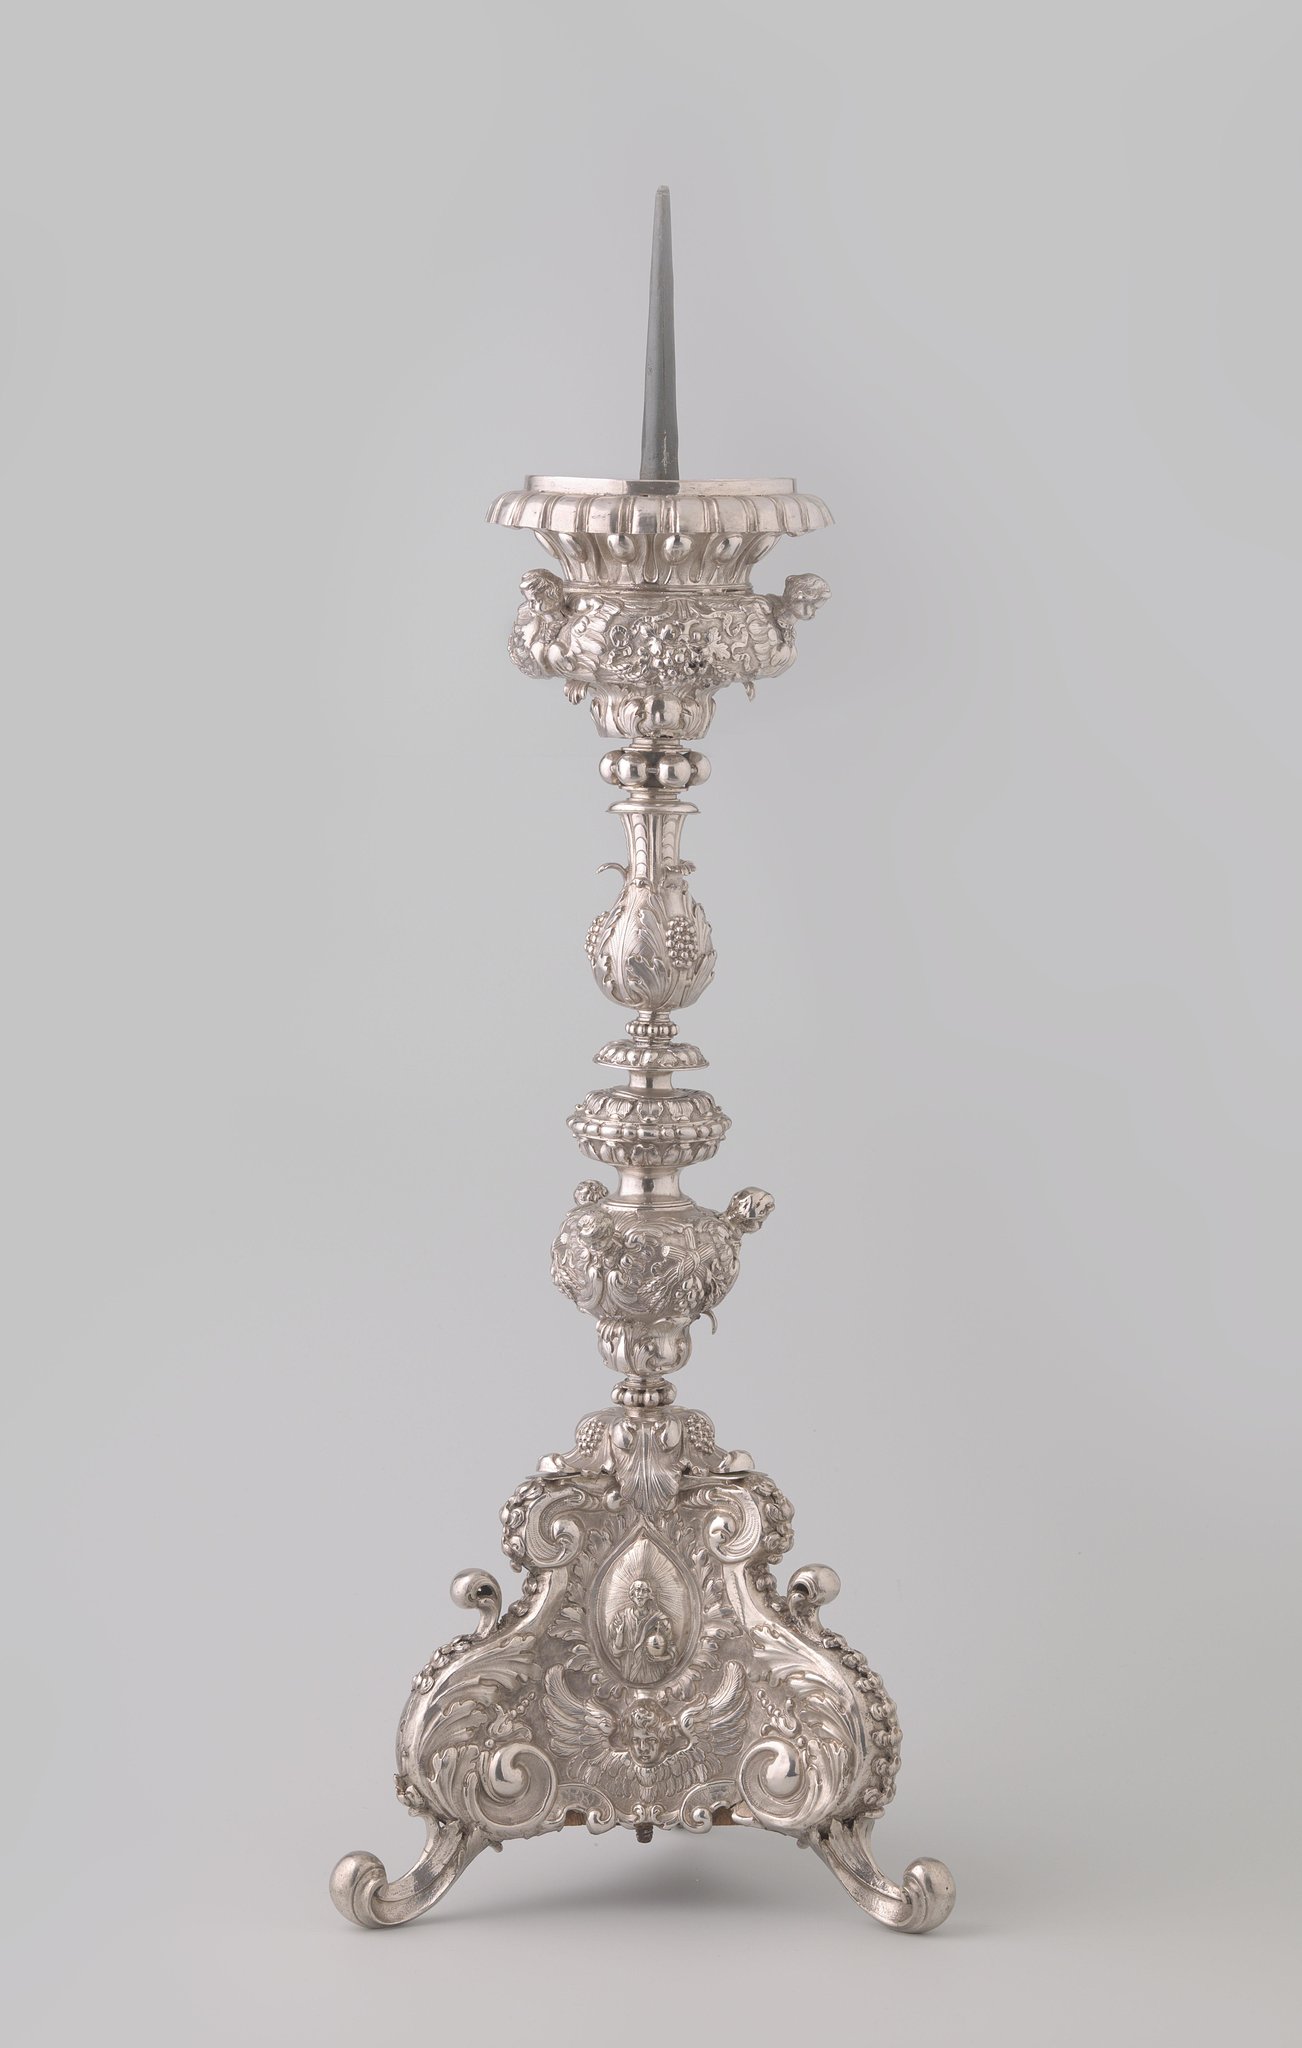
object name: kerkkandelaar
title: Kandelaar van zilver met balusterstam in vijf geledingen op driehoekig voetstuk op voluutpoten. Versierd met medaillons met Christus, Petrus en Ignatius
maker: jos hannekin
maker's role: silversmith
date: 1701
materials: silver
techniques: gilding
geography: antwerp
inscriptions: mark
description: Six altar candlesticks. Silver. Antwerp, 1701, by Jos Hannekin.